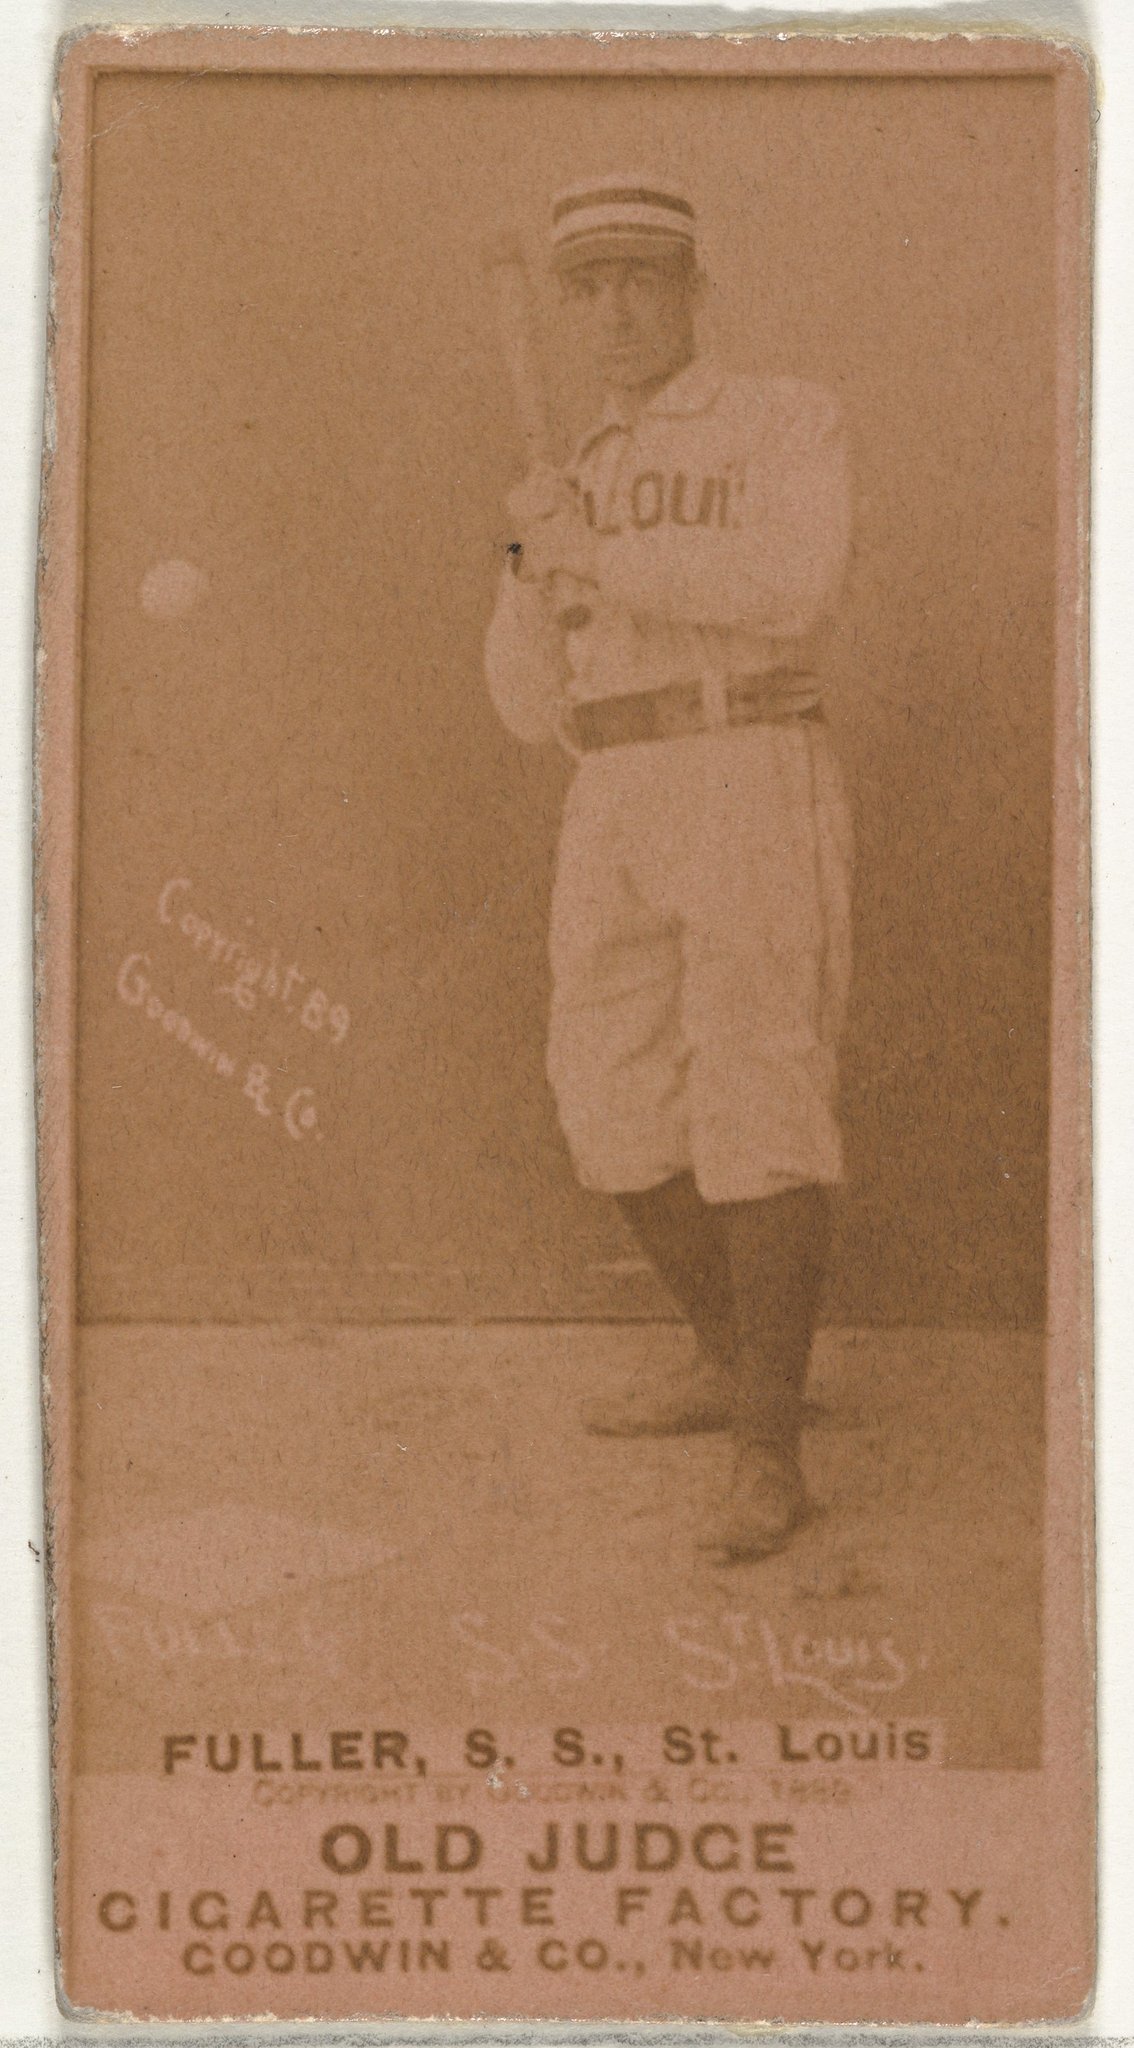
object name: baseball card, photograph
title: William Benjamin "Shorty" Fuller, Shortstop, St. Louis Browns, from the Old Judge series (N172) for Old Judge Cigarettes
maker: goodwin & company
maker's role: publisher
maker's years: 1850-1950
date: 1889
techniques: albumen silver print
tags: men,portraits,baseball,athletes